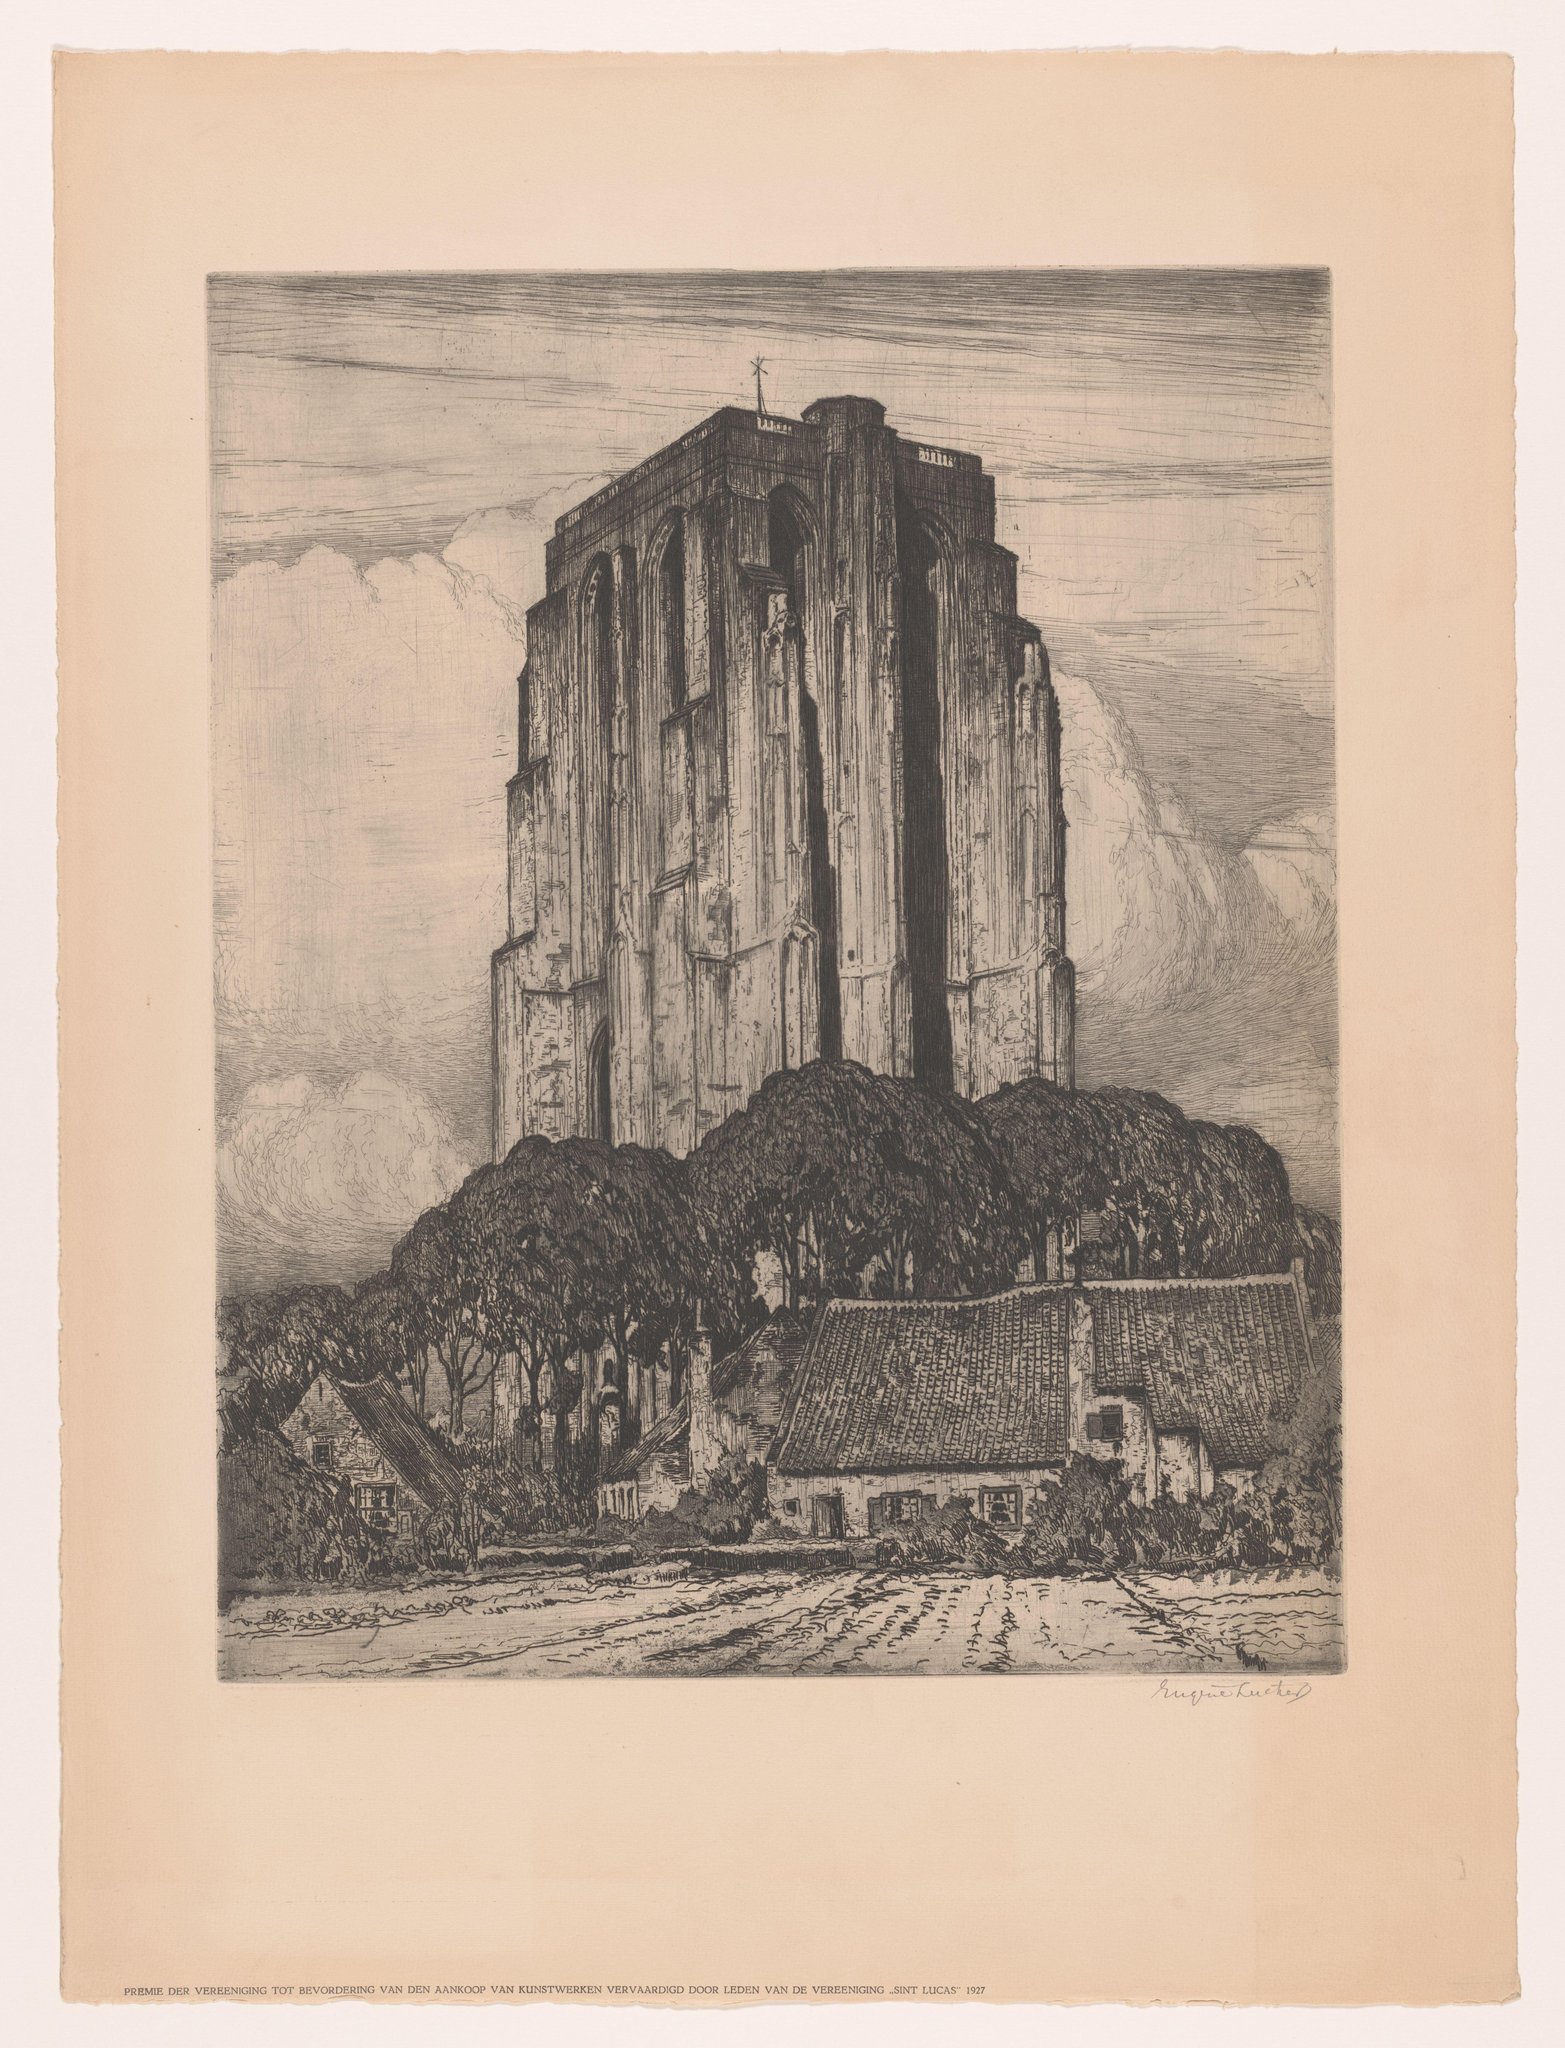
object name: print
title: Gezicht op de Sint-Lievensmonstertoren te Zierikzee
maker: eugène lücker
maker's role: print maker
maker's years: 1876-1943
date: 1927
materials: paper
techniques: drypoint, etching, intaglio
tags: church (exterior)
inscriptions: collector's mark: Lugt 2228, inscription: ‘Premie der Vereeniging tot Bevordering van den aankoop van kunstwerken vervaardigd door leden van de vereeniging "Sint Lucas" 1927’